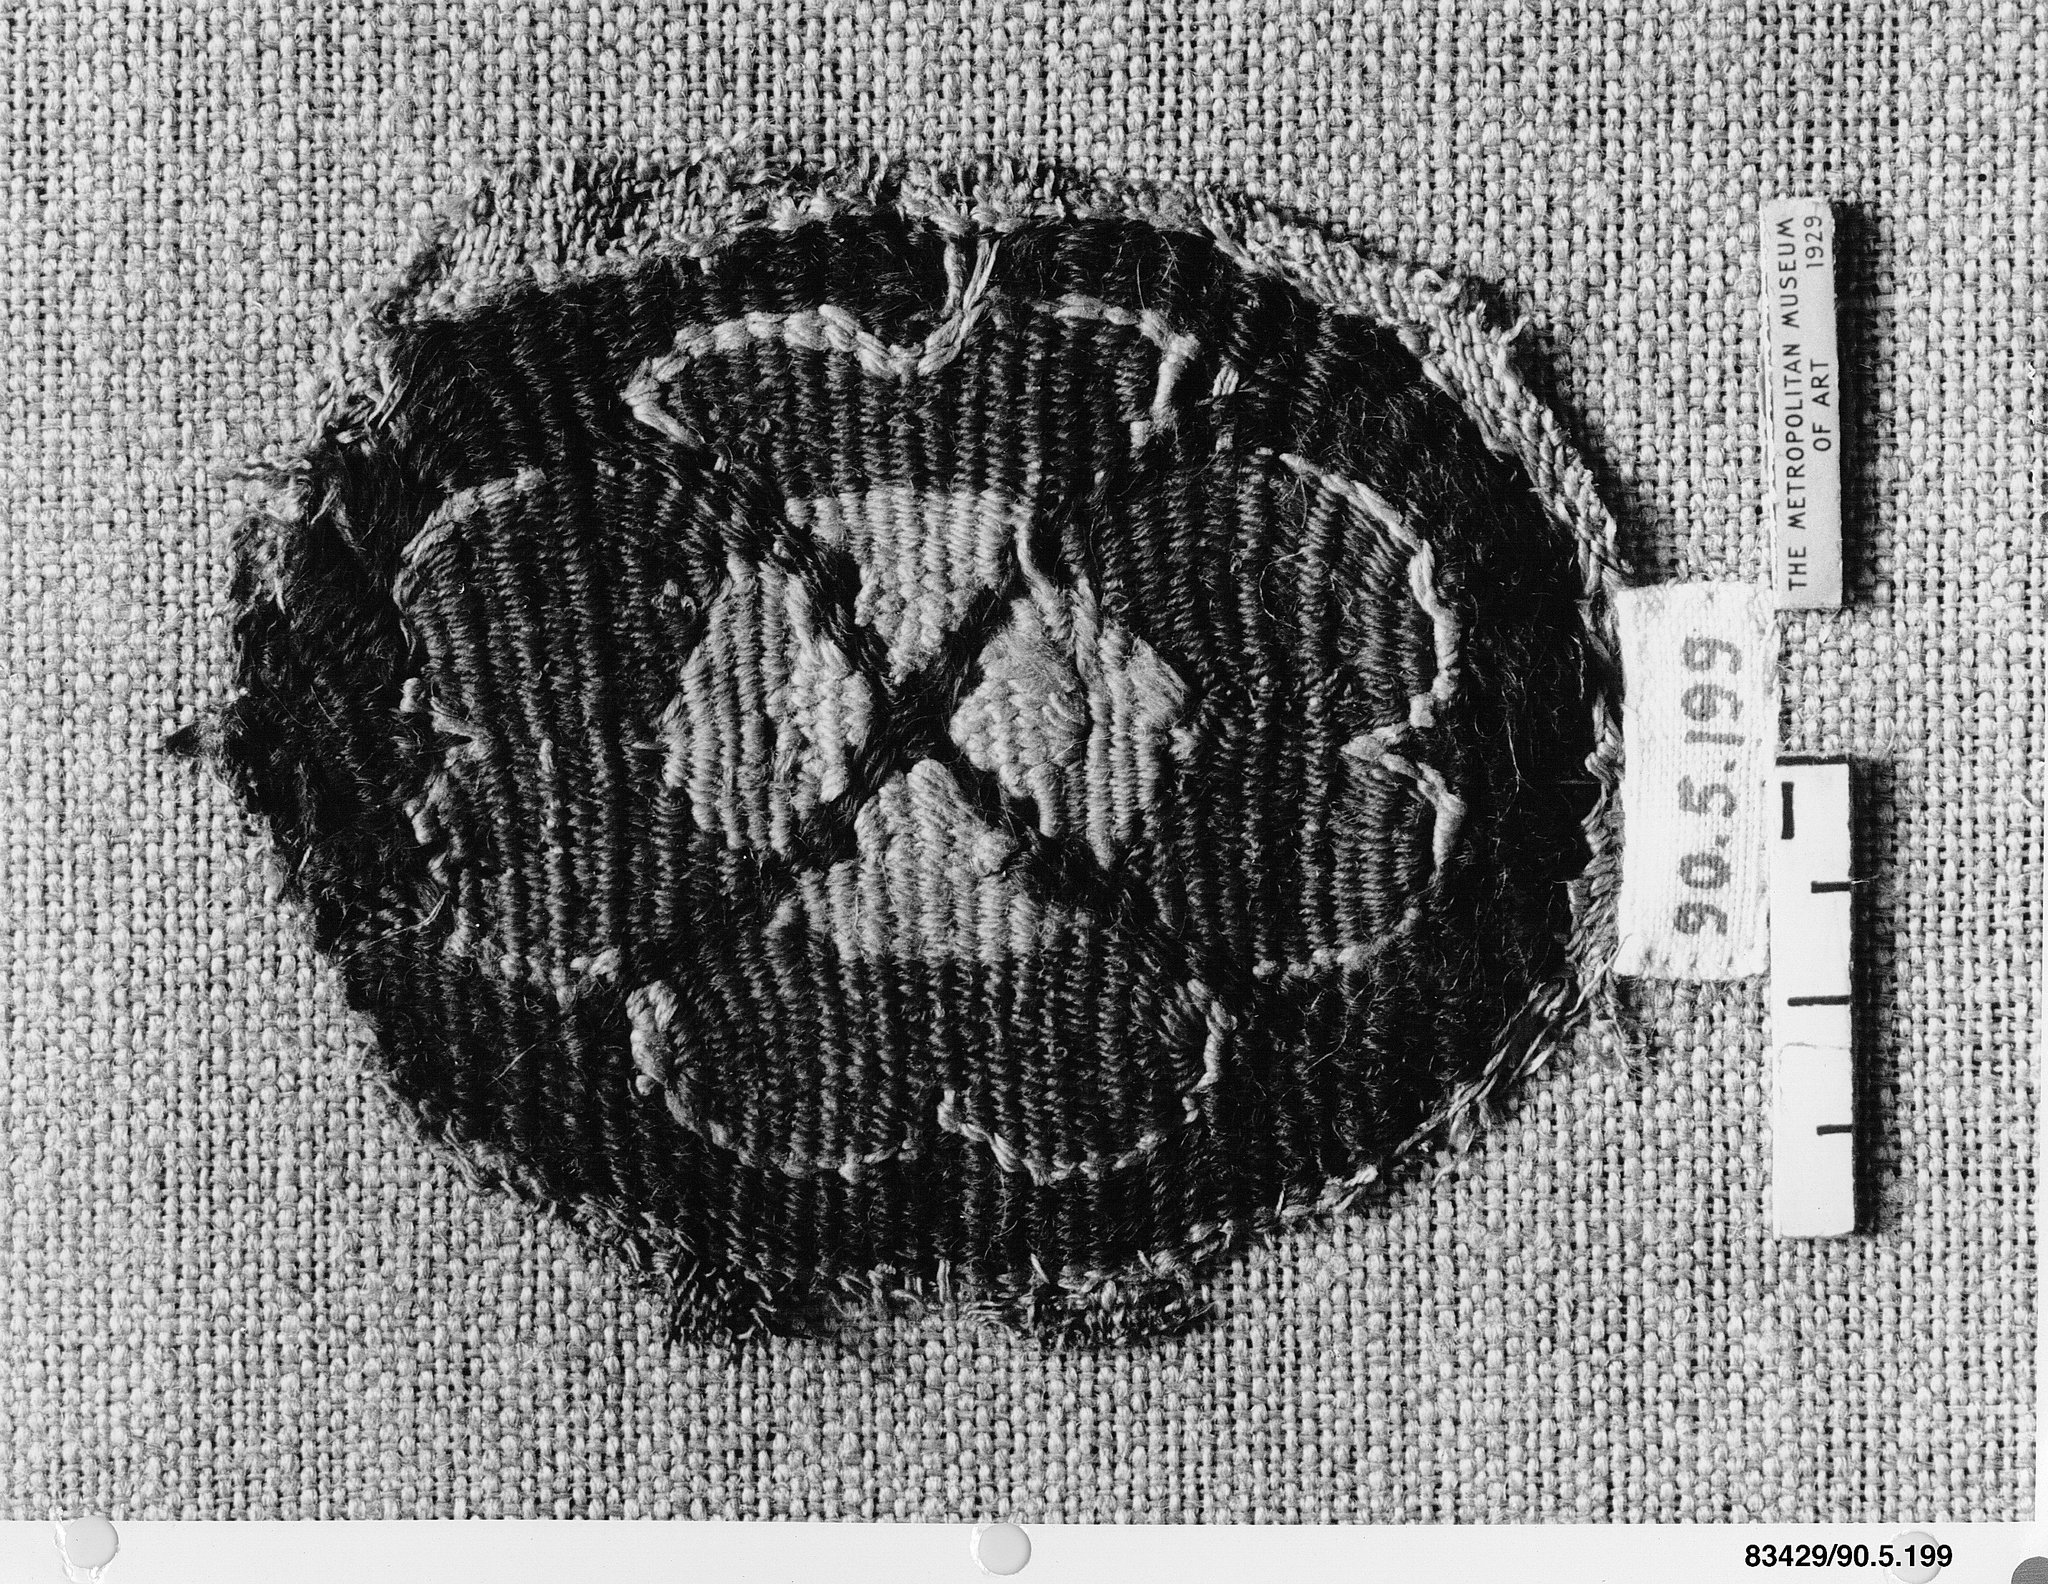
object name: textile fragment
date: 301-500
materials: linen, wool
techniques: weave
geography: egypt